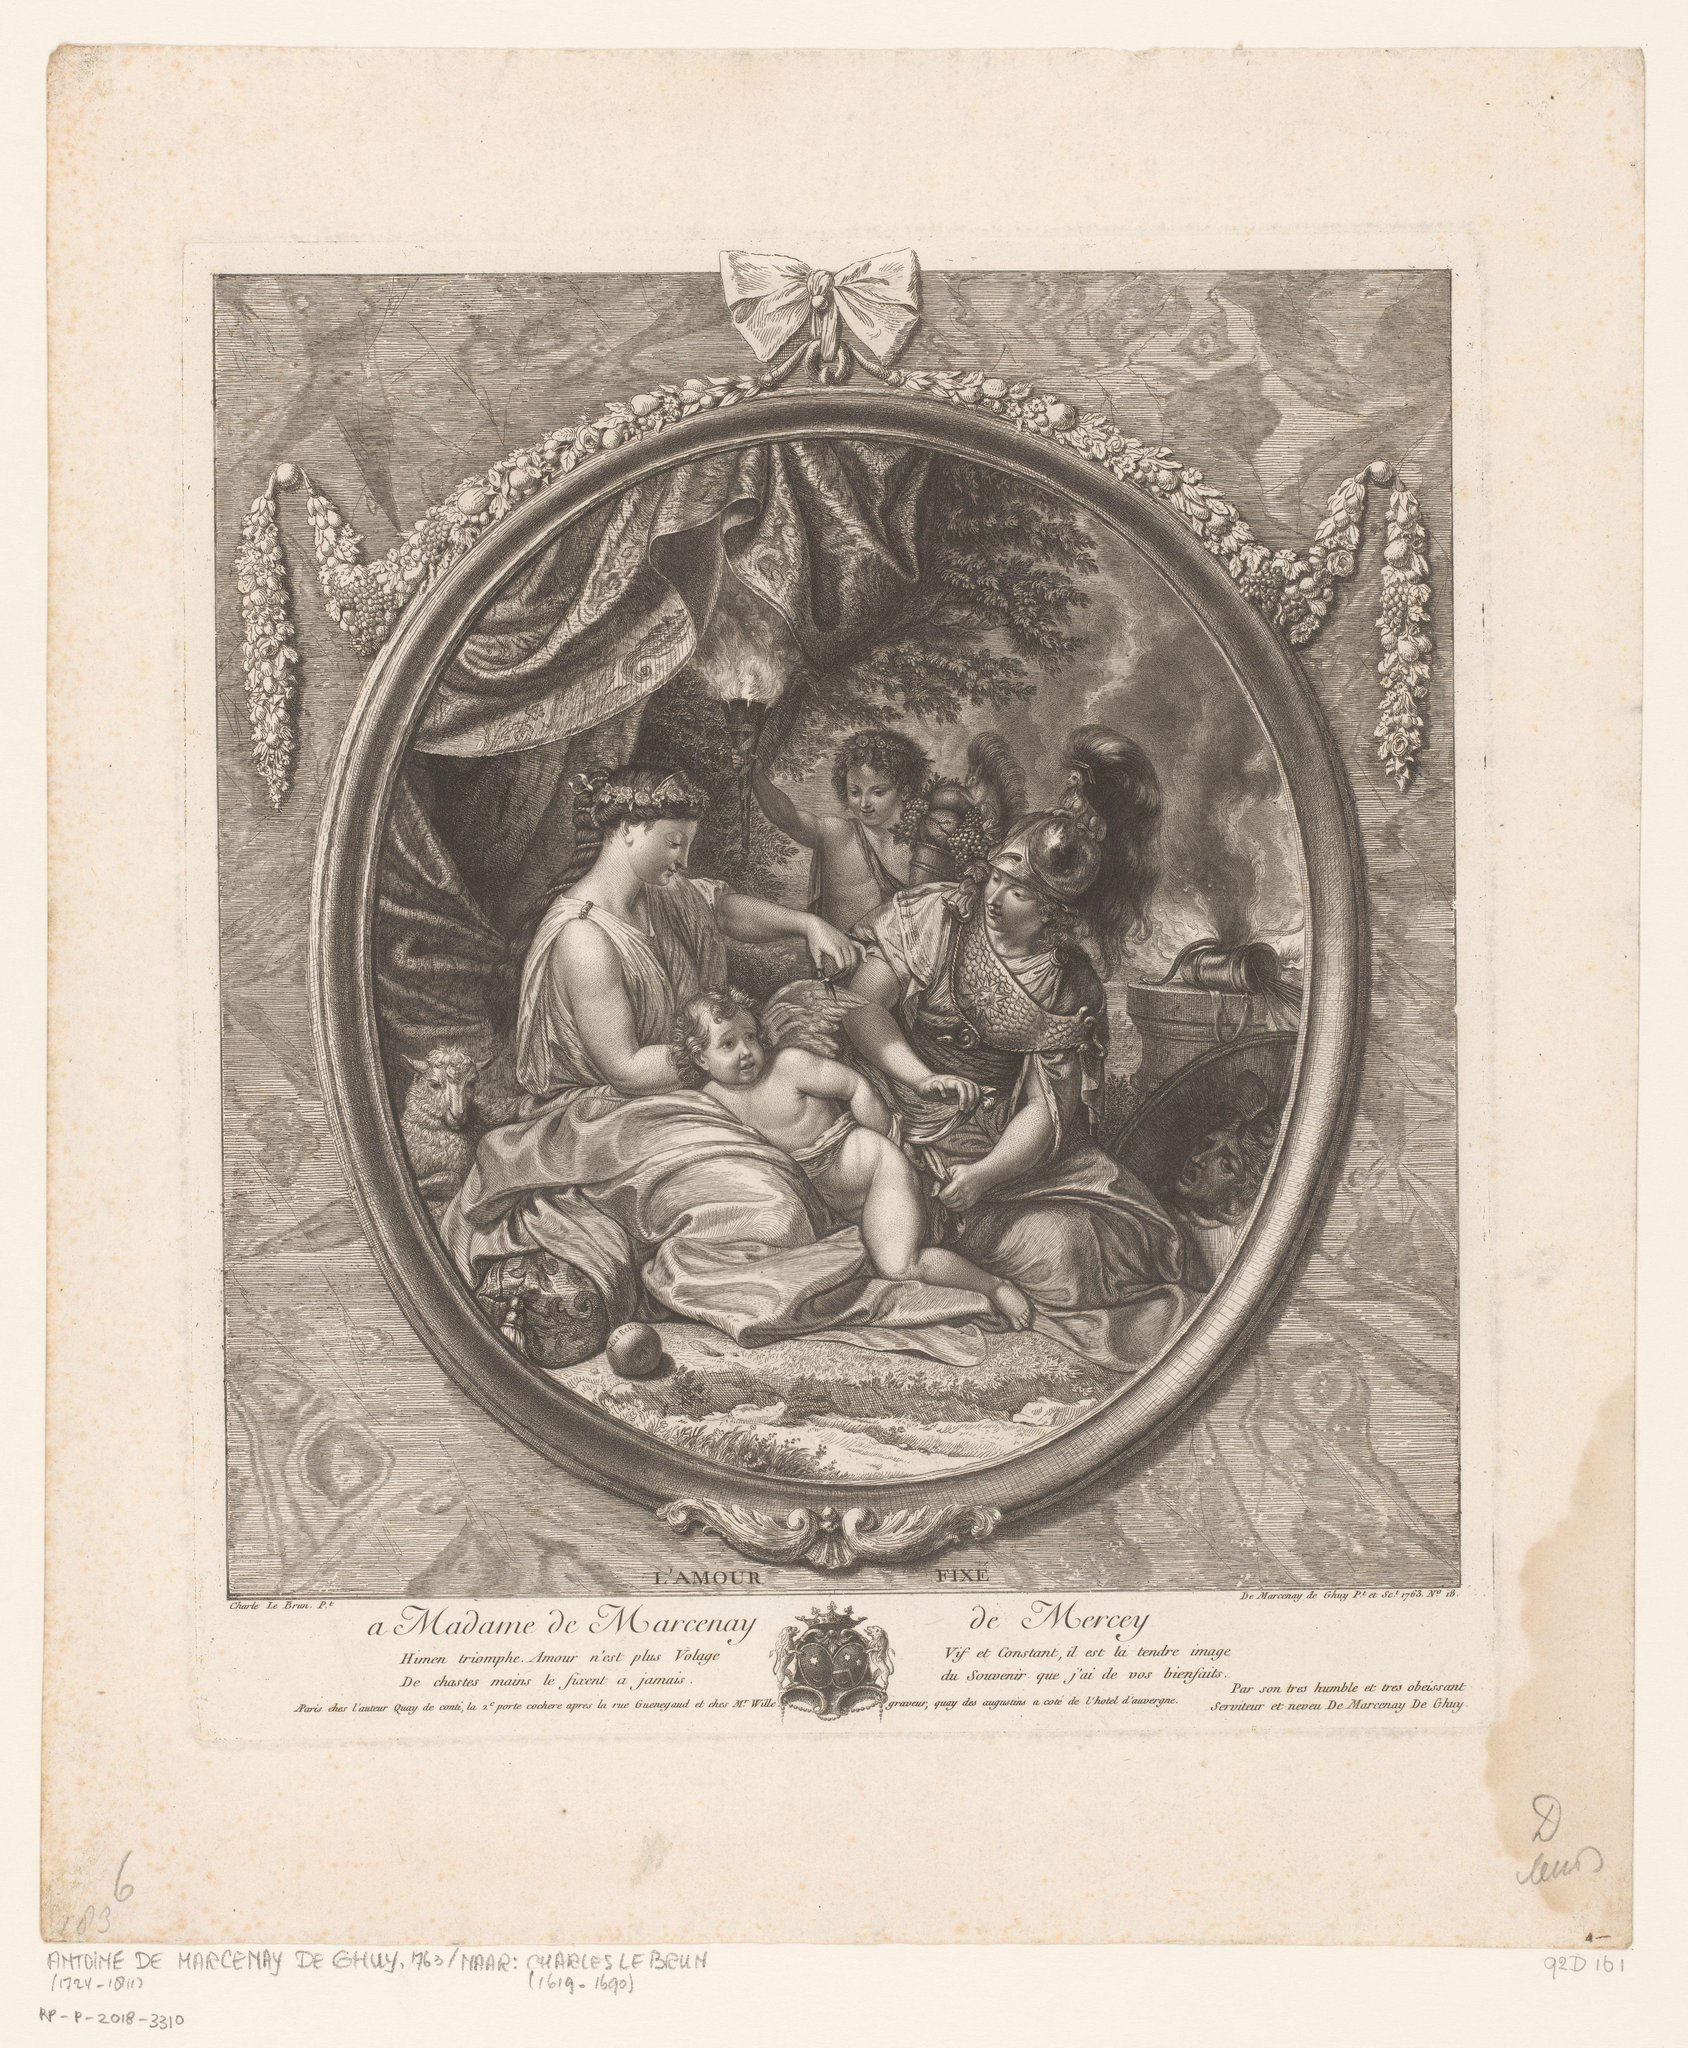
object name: print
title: Vleugels van Amor worden afgeknipt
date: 1763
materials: paper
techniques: engraving, etching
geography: paris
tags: punishment of cupid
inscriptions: collector's mark: Lugt 2228